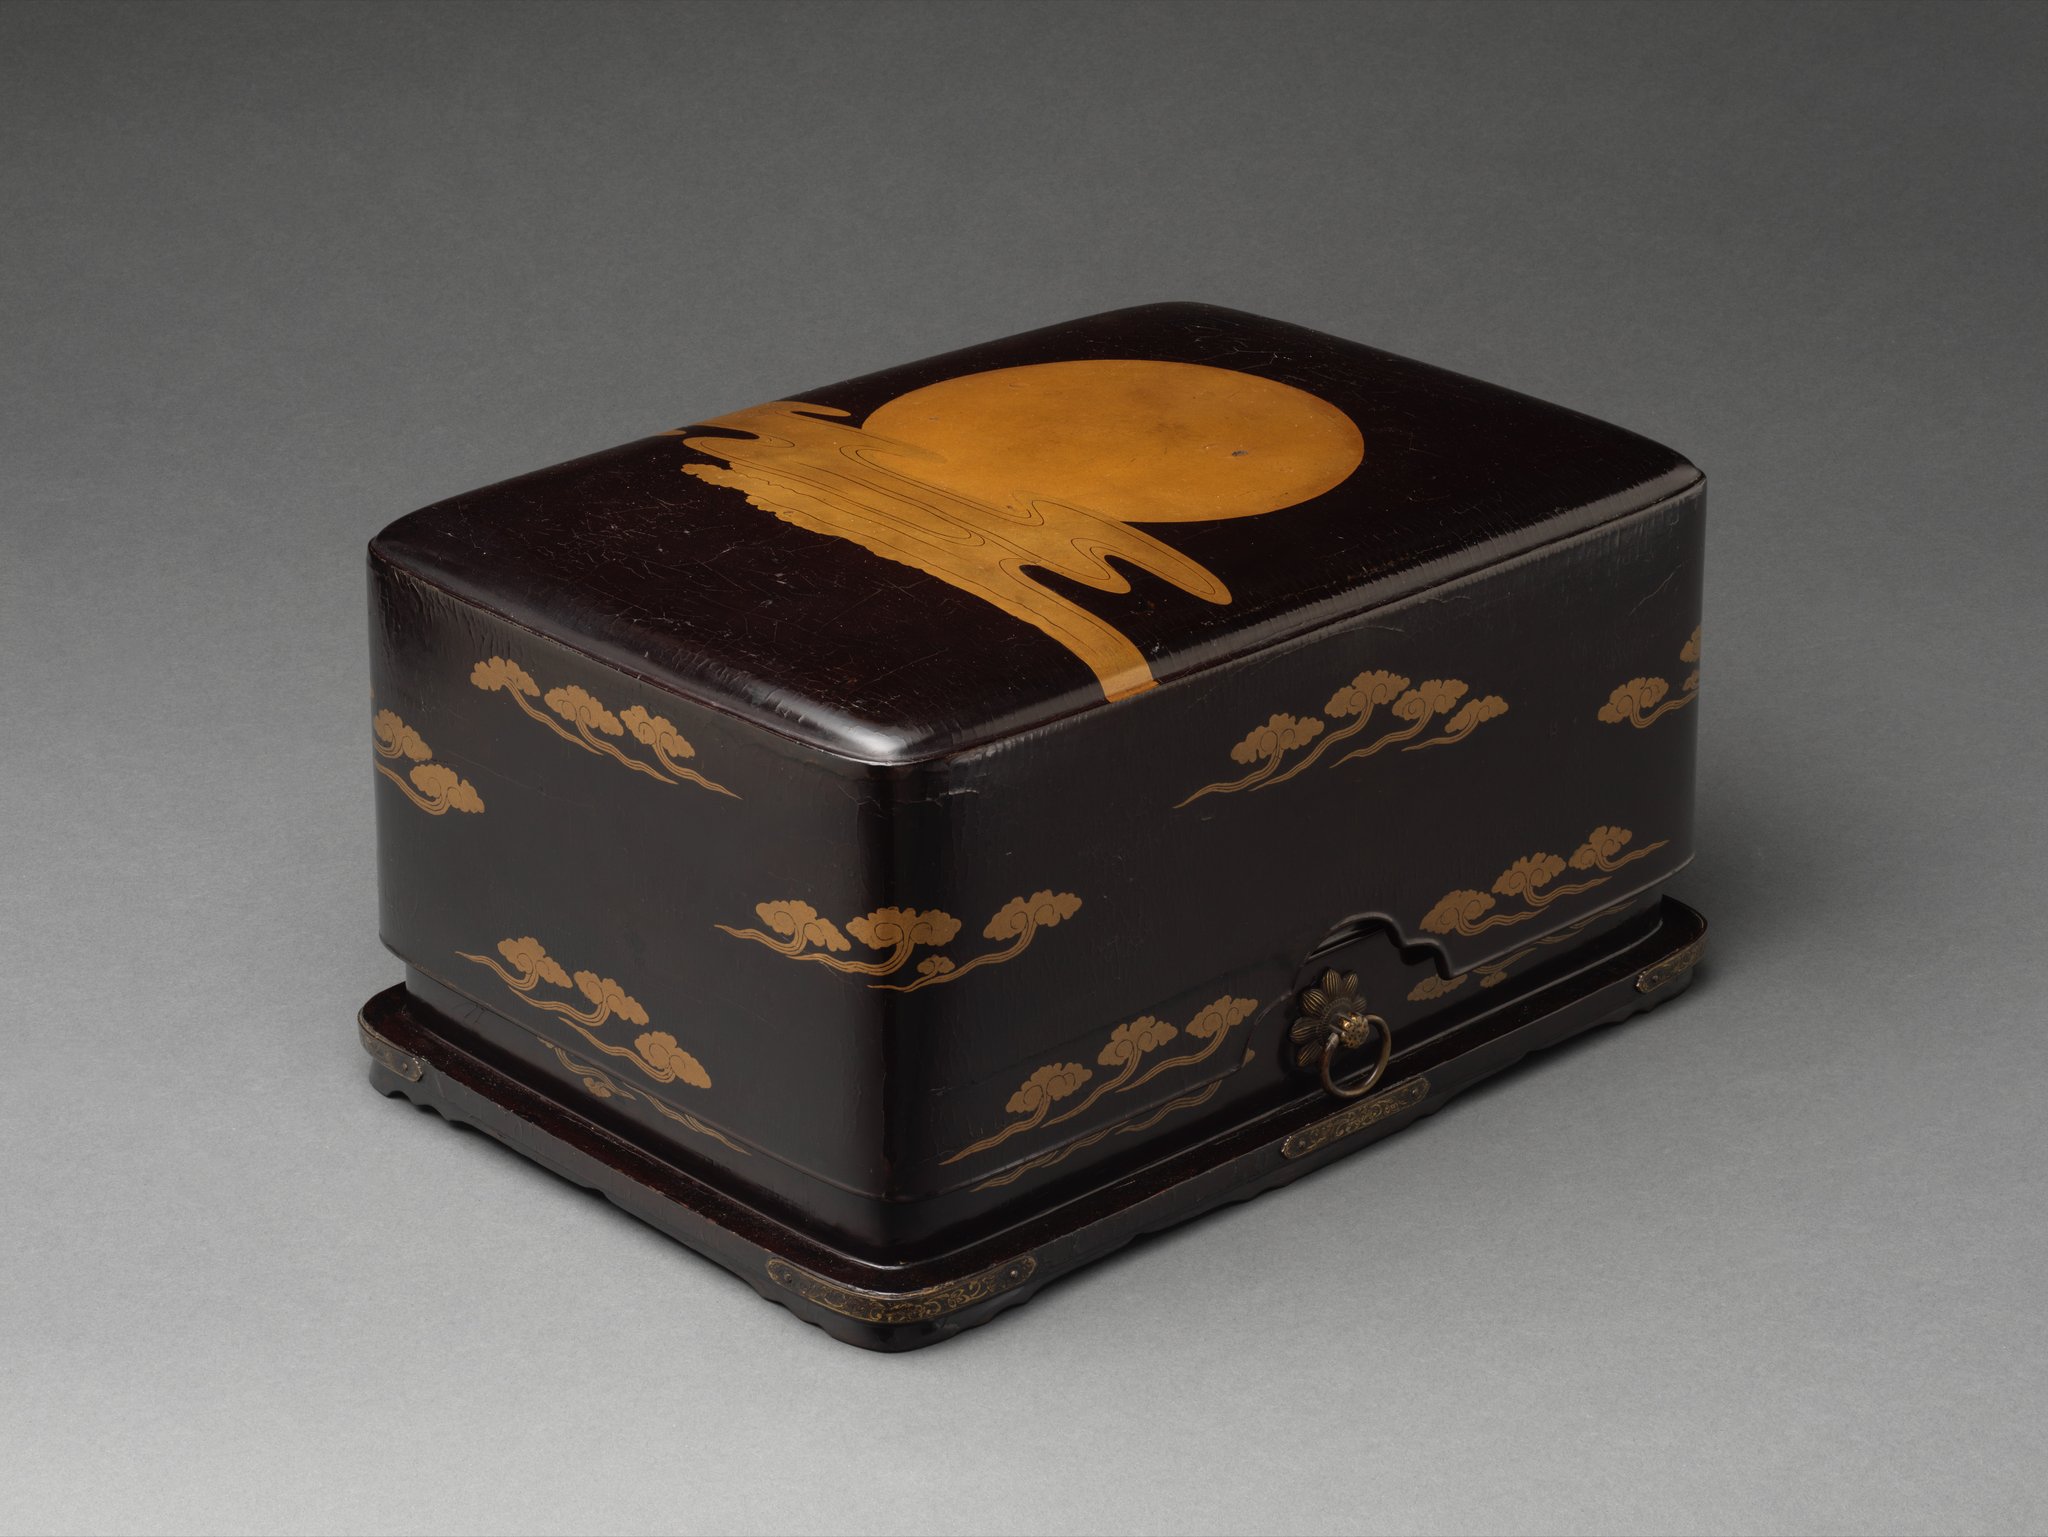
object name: sutra box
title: Sutra Box (Kyōbako) with Sun and Clouds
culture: japanese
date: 1367-1433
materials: gilt bronze, gold, wood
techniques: hiramakie, lacquer